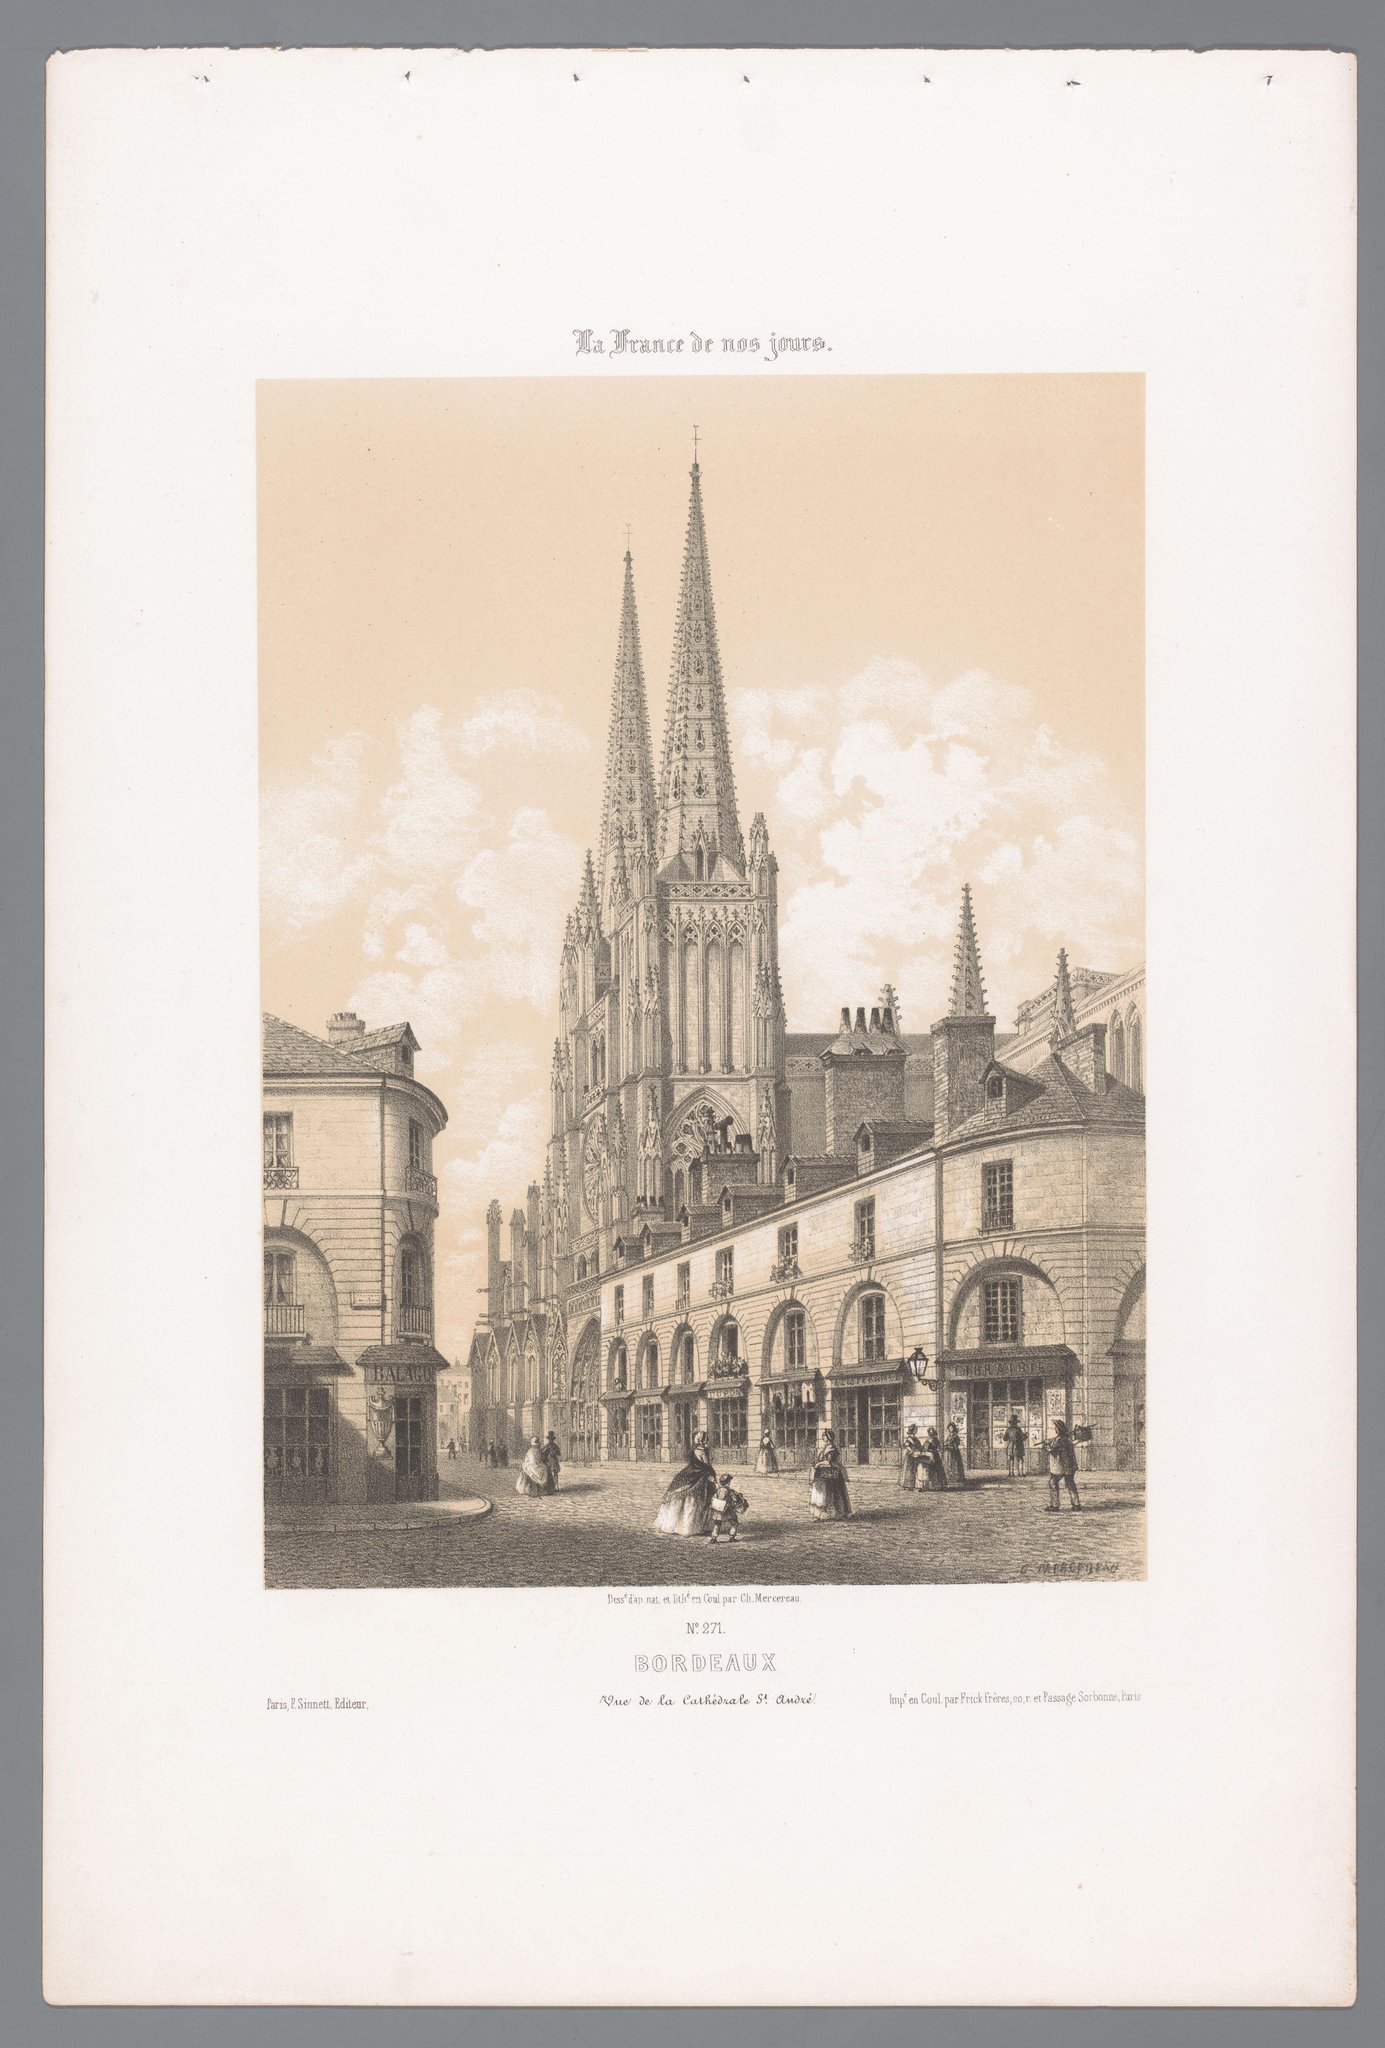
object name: print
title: Hedendaags Frankrijk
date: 1856-1874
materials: paper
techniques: tone lithography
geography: paris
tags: fashion, clothing, city-view, and landscape with man-made constructions, church (exterior)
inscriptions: collector's mark: Lugt 2228